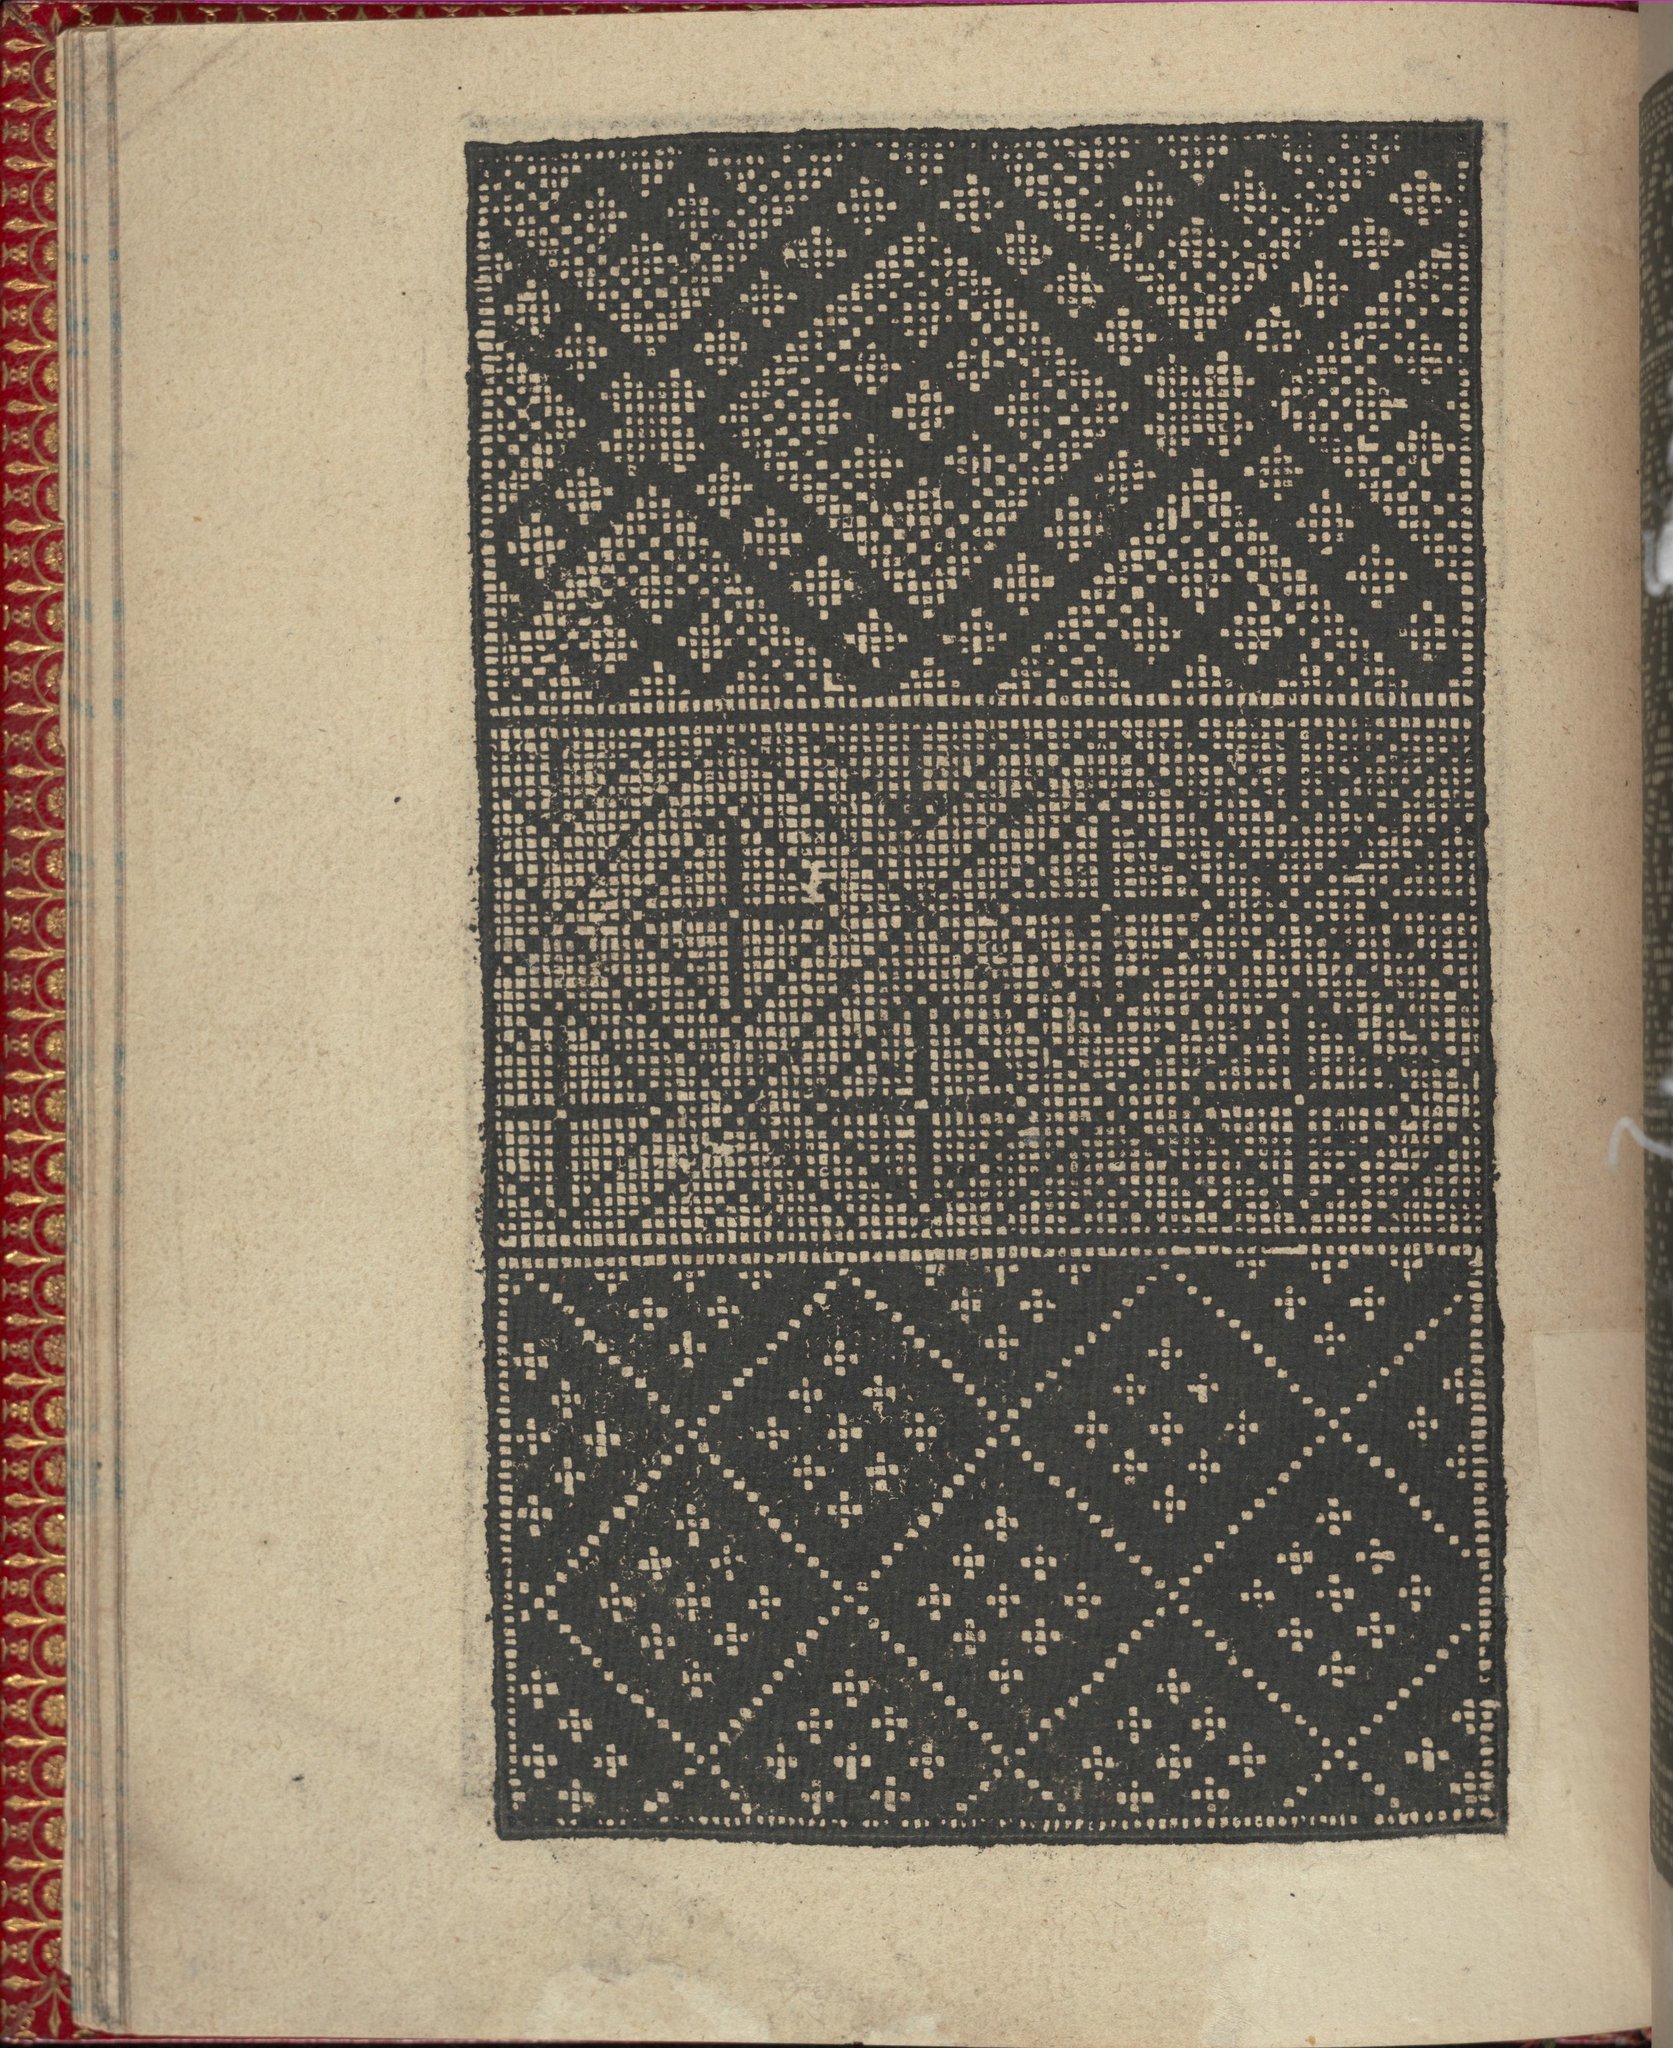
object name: book print ornament architecture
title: Ce est ung tractat de la noble art de leguille ascavoir ouvraiges de spaigne... page 16 (verso)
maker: willem vosterman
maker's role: printer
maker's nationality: netherlandish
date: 1527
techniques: woodcut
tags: ornament